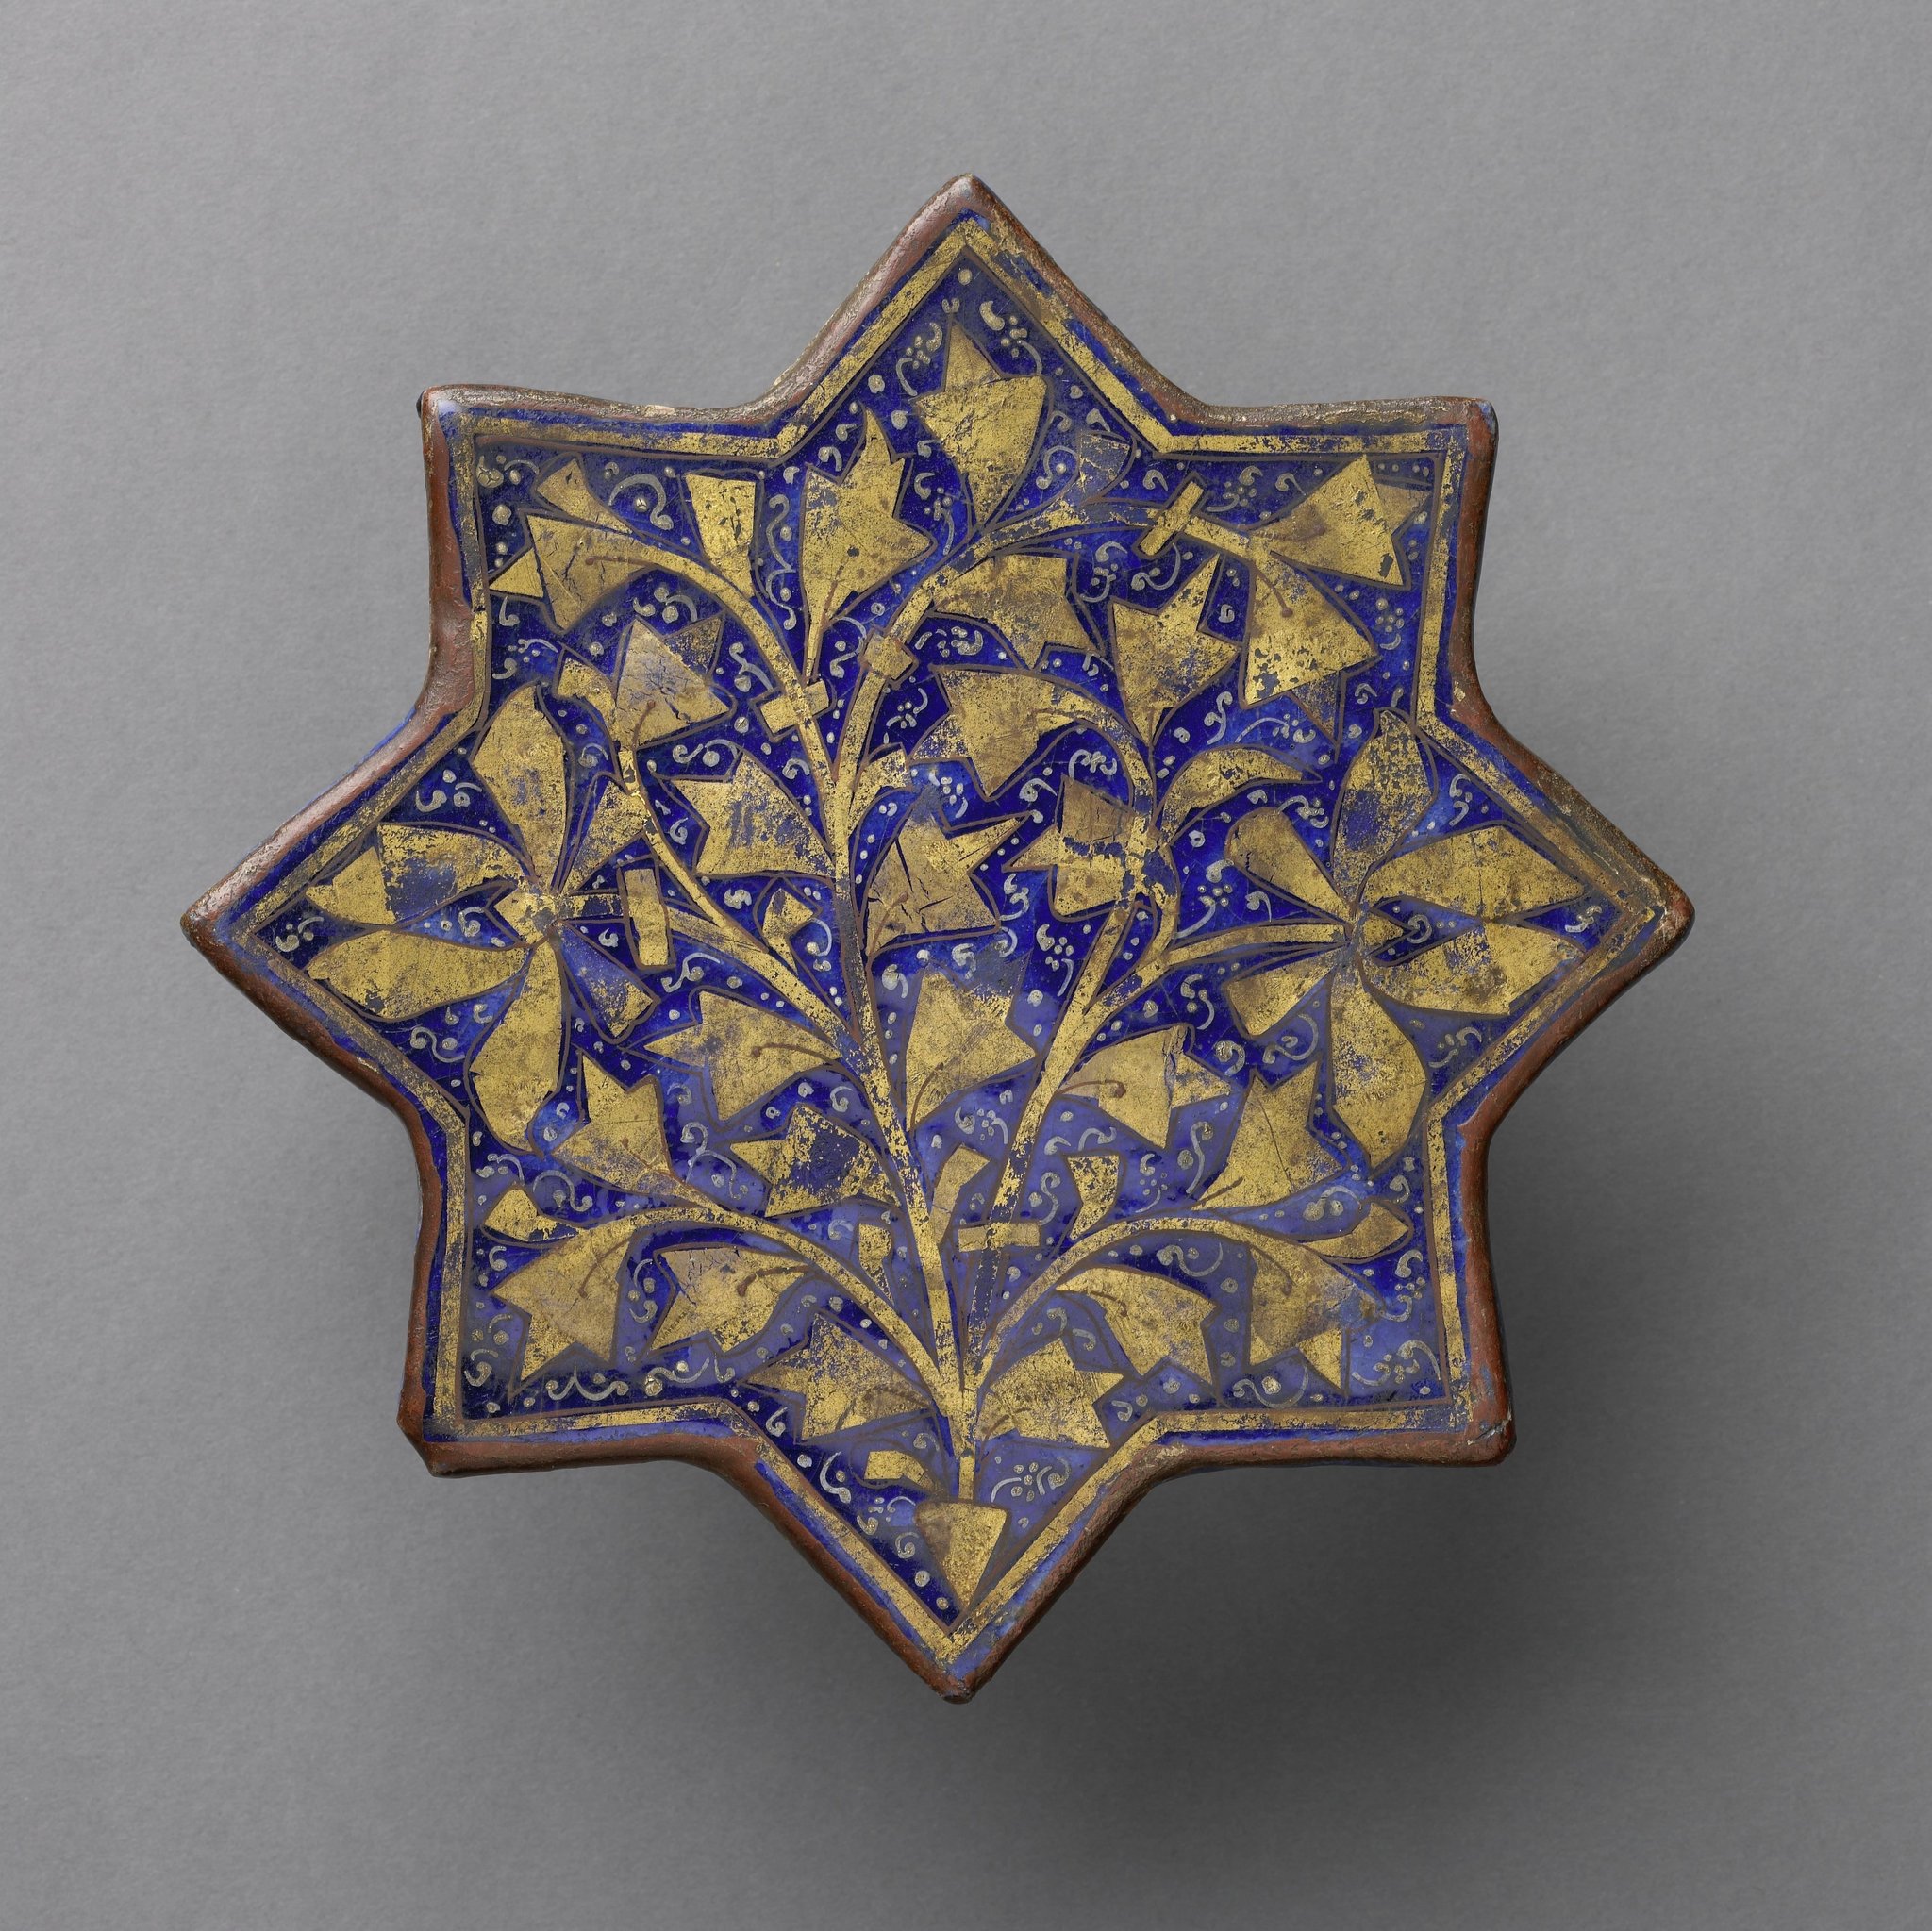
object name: tile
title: Star-shaped tile with a stylized flowering plant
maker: Anonymous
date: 1250-1299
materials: cobalt, earthenware, glaze, gold, paint, quartz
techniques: firing, forming, vitrification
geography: iran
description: Stervormige tegel met een gestileerde bloeiende plant (lotus) en florale motieven in goud op een kobalt blauwe ondergrond. Ladjvardina.